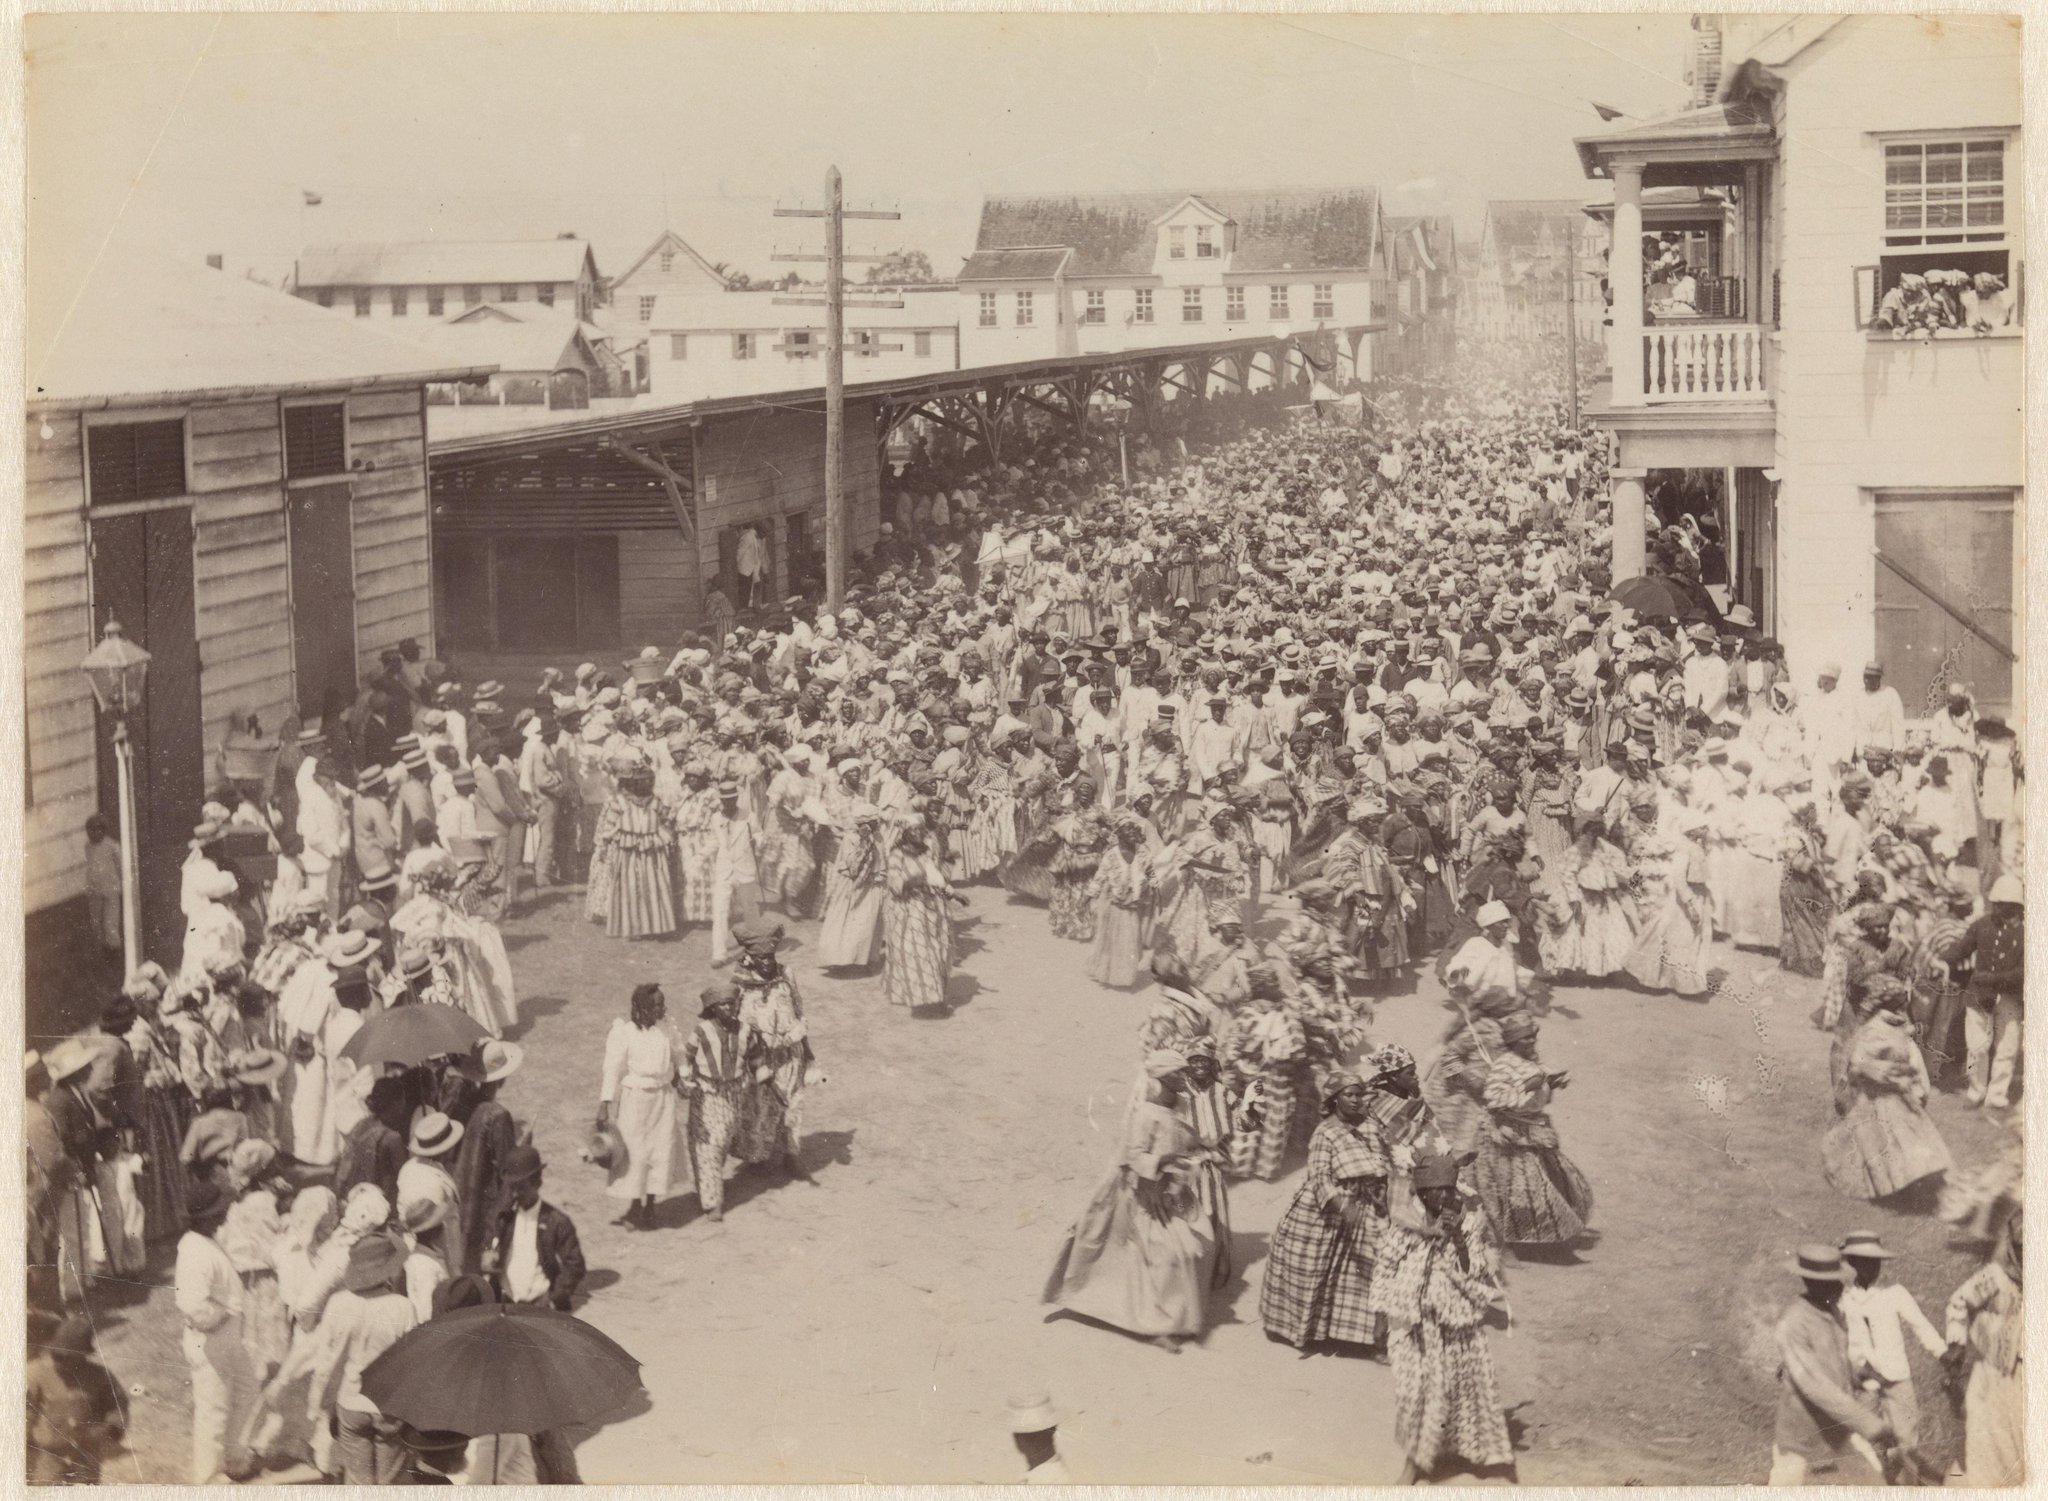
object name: photograph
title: Optocht Marktmeiden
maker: julius muller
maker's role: official, politician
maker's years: 1846-1902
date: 1882-1902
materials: photographic support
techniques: albumen print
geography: suriname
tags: waterkant, paramaribo (stad)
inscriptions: inscription: ‘Optocht Marktmeiden’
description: Optocht van een grote groep mensen, grotendeels vrouwen in koto misi, die over de Waterkant lopen langs de overdekte markt ter hoogte van het Waaggebouw.